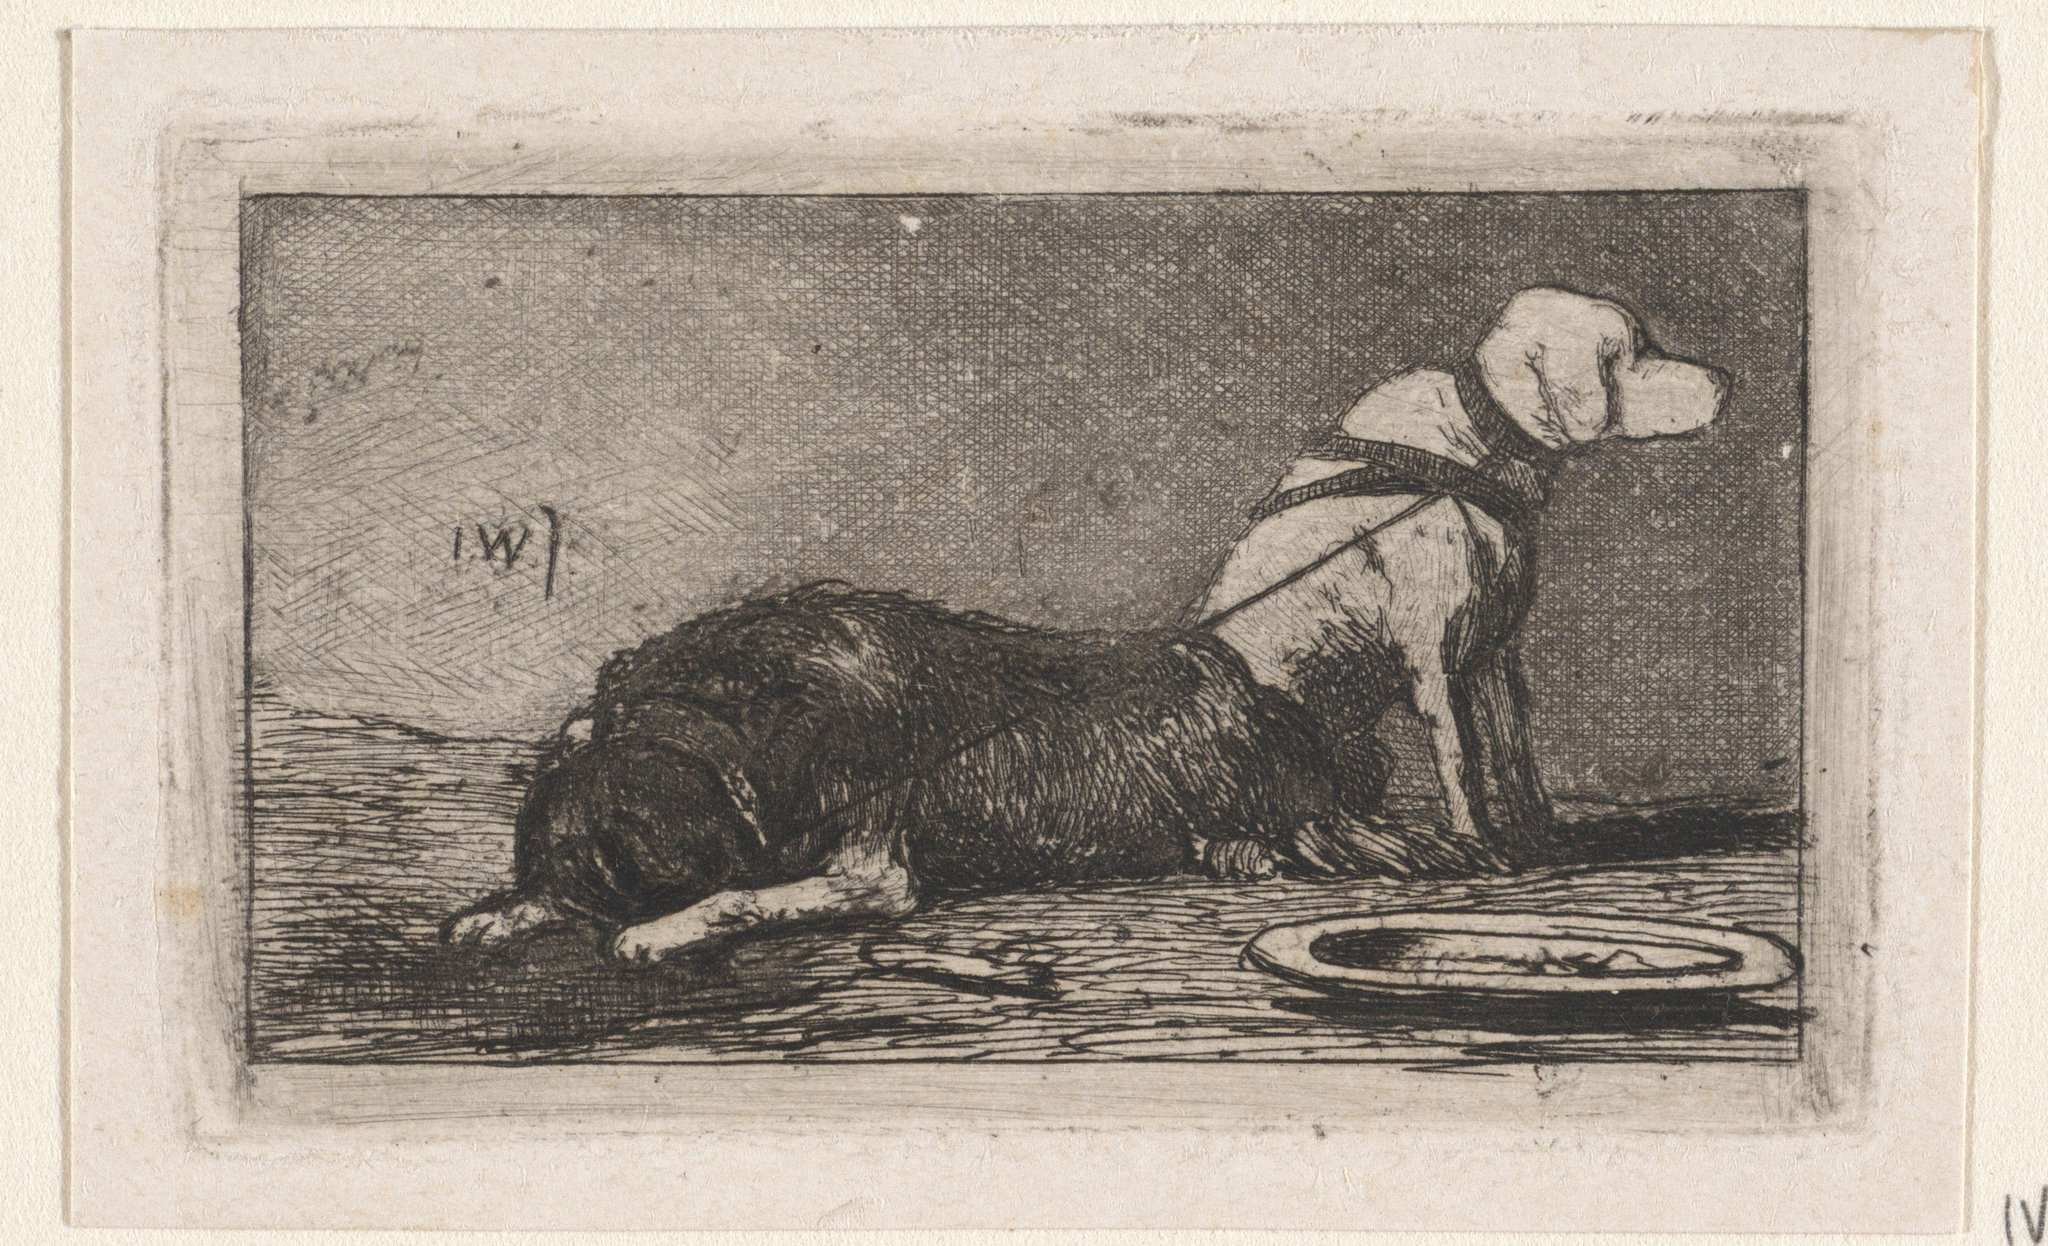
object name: print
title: Twee vastgebonden honden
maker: jan weissenbruch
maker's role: painter, print maker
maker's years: 1822-1880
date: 1837-1880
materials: paper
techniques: etching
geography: the hague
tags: animals tied up, dish, plate, saucer, dog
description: Een hond ligt op de grond naast een bot. Hij is vastgebonden aan de tweede hond die achter hem zit. Rechts vooraan staat een leeg bord.